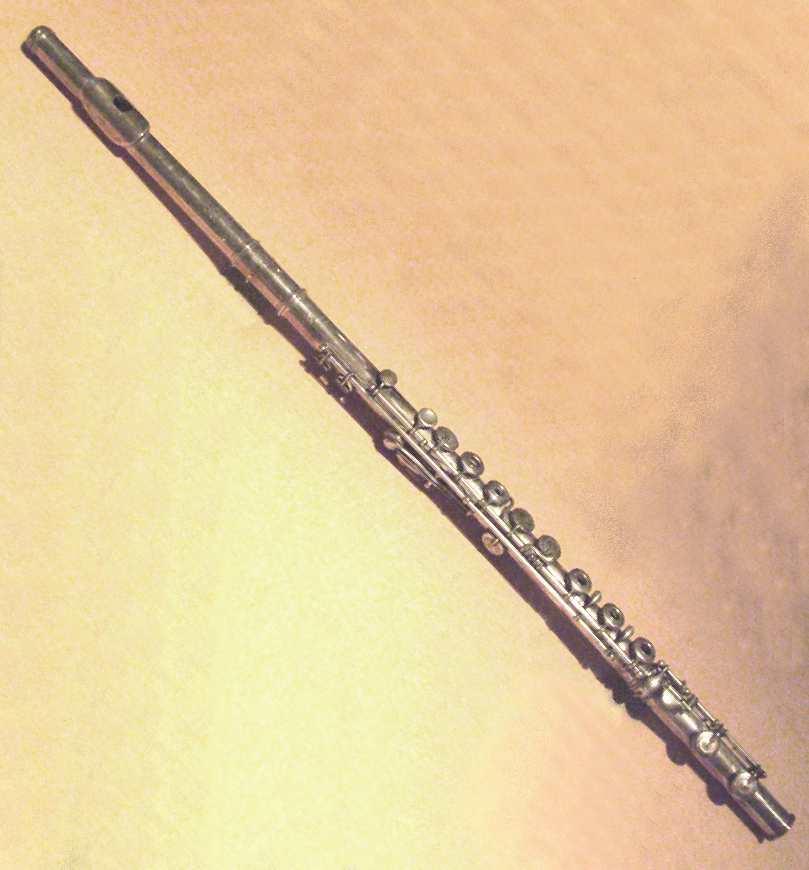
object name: transverse flute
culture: french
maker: clair godfroy aine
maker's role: maker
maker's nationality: french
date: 1855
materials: silver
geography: france